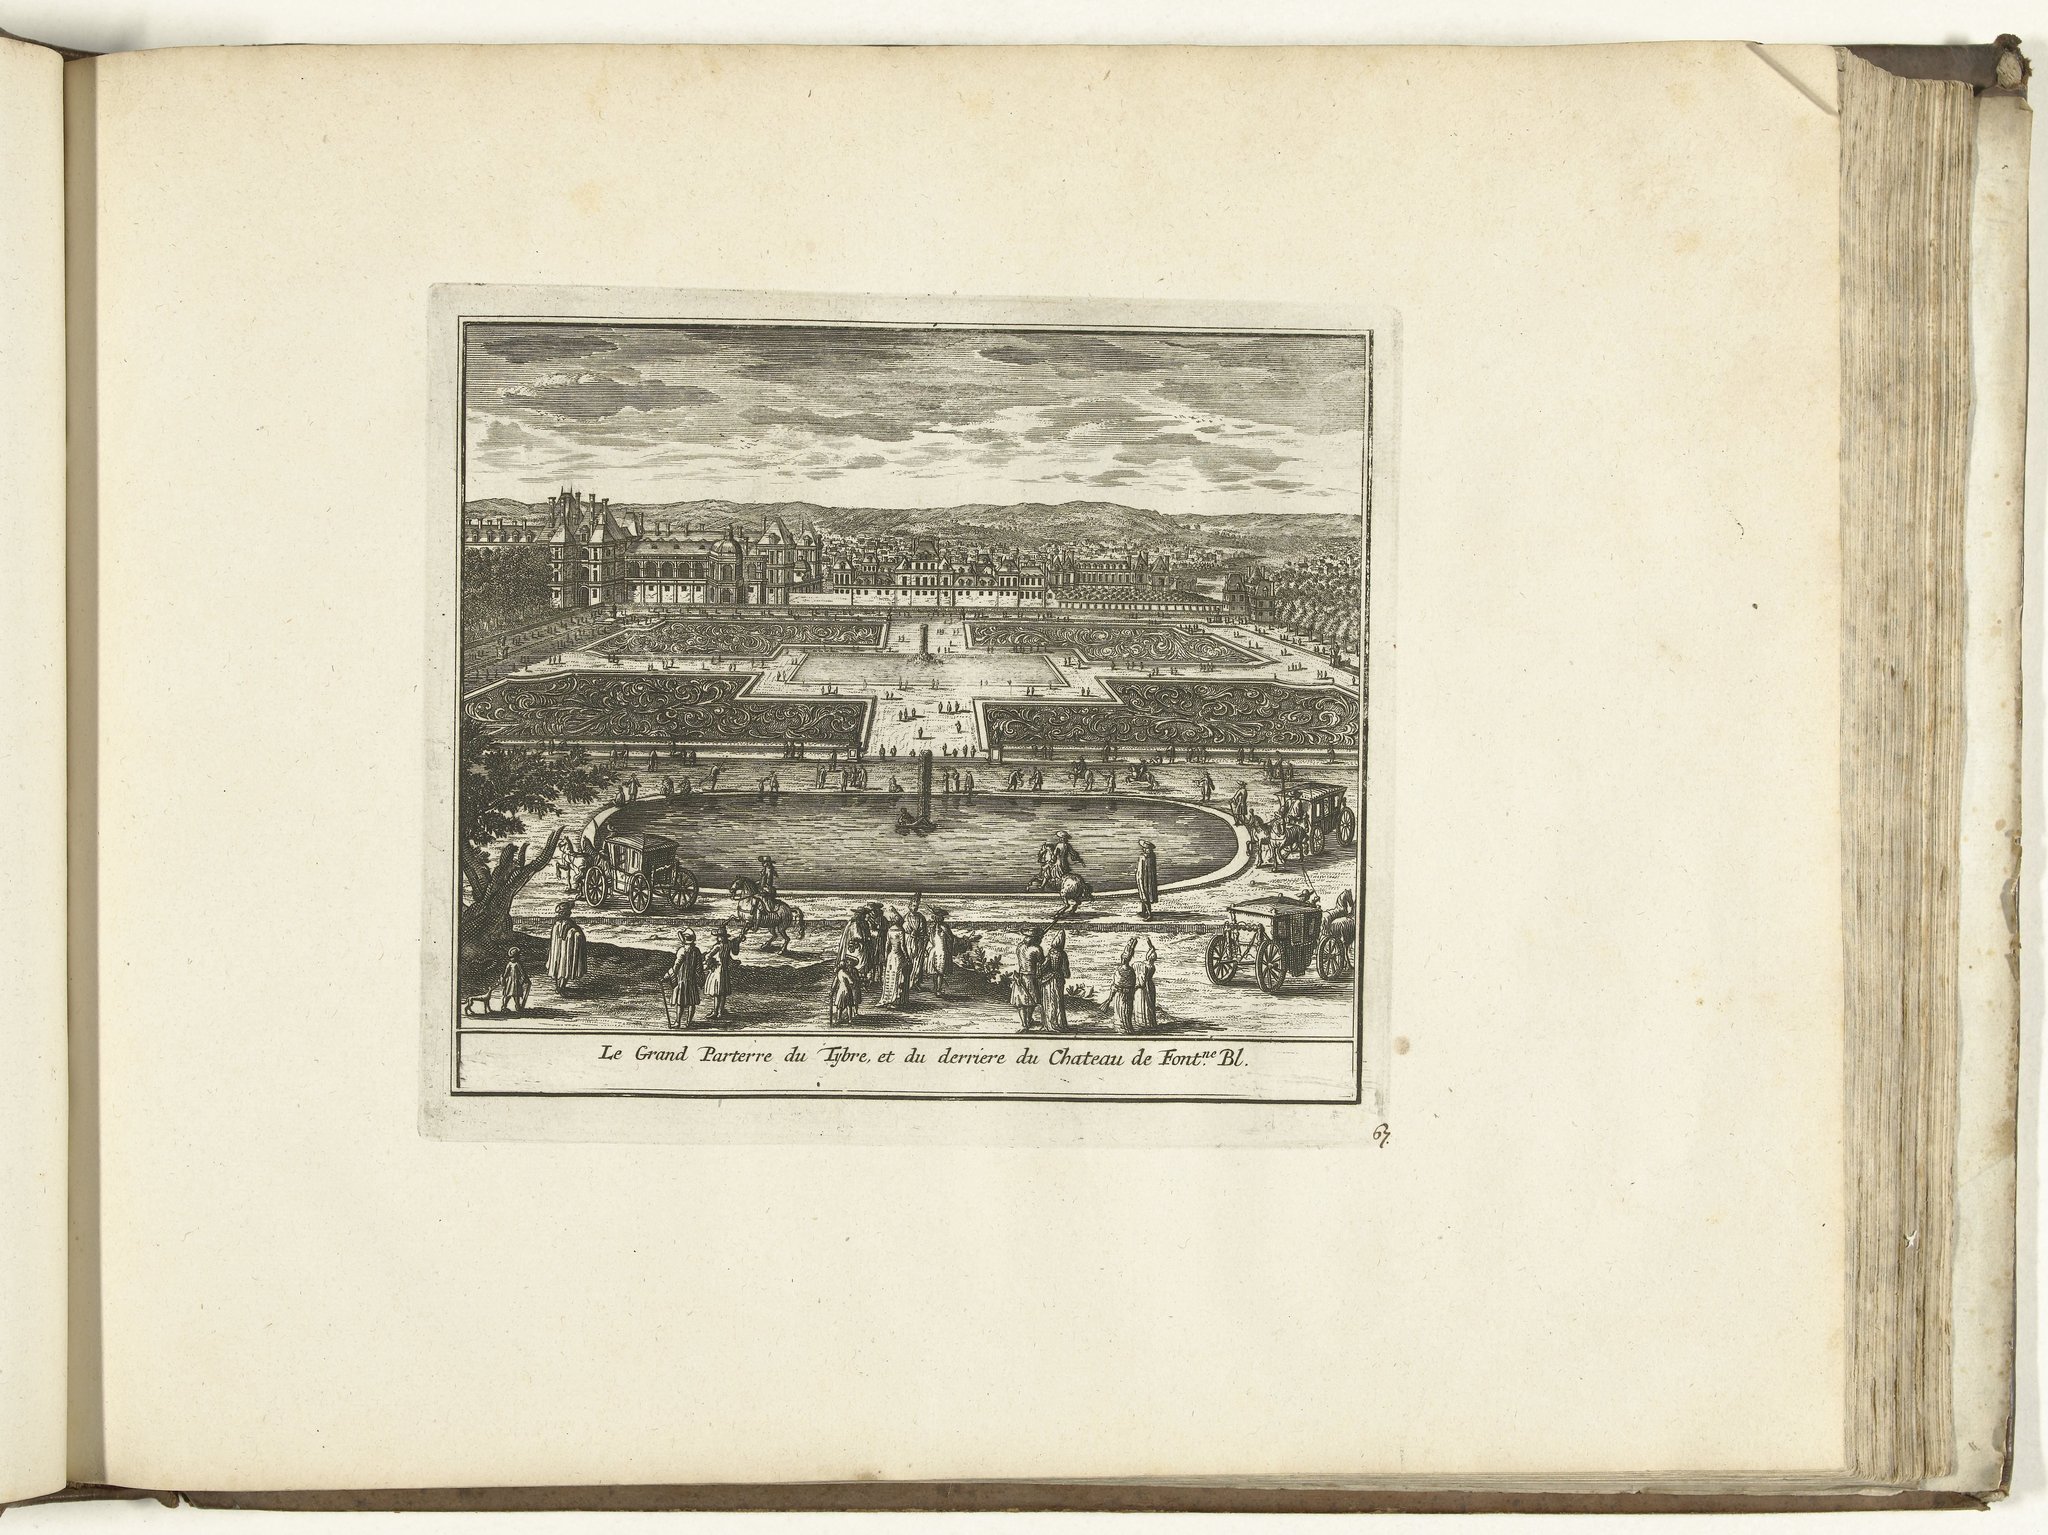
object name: print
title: Gezicht op de Parterre en de Bassin de Tibre in het paleis van Fontainebleau, 1726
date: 1726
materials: paper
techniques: etching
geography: northern netherlands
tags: palace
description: Gezicht op de Parterre en de Bassin de Tibre in het paleis van Fontainebleau. Plaat nr. 67 in deel III van het prentwerk: Les Forces de l'Europe, Asie, Afrique et Amerique ... Comme aussi les Cartes des Côtes de France et d'Espagne uit 1726, dit eerste deel met 238 met de hand genummerde platen van vermaarde sterke steden en vestingen in het kader van de Spaanse Successieoorlog 1701-1713. Voor het merendeel zijn deze platen gekopieerd naar de anonieme Franse platen van vermaarde sterke steden en vestingen: in Les forces de l'Europe en in: Le theatre de la guerre, dans les Pays-Bas, beide oorspronkelijk uitgegeven door Nicolas de Fer te Parijs (1693-1697) in het kader van de Negenjarige Oorlog. Titel in het Frans.